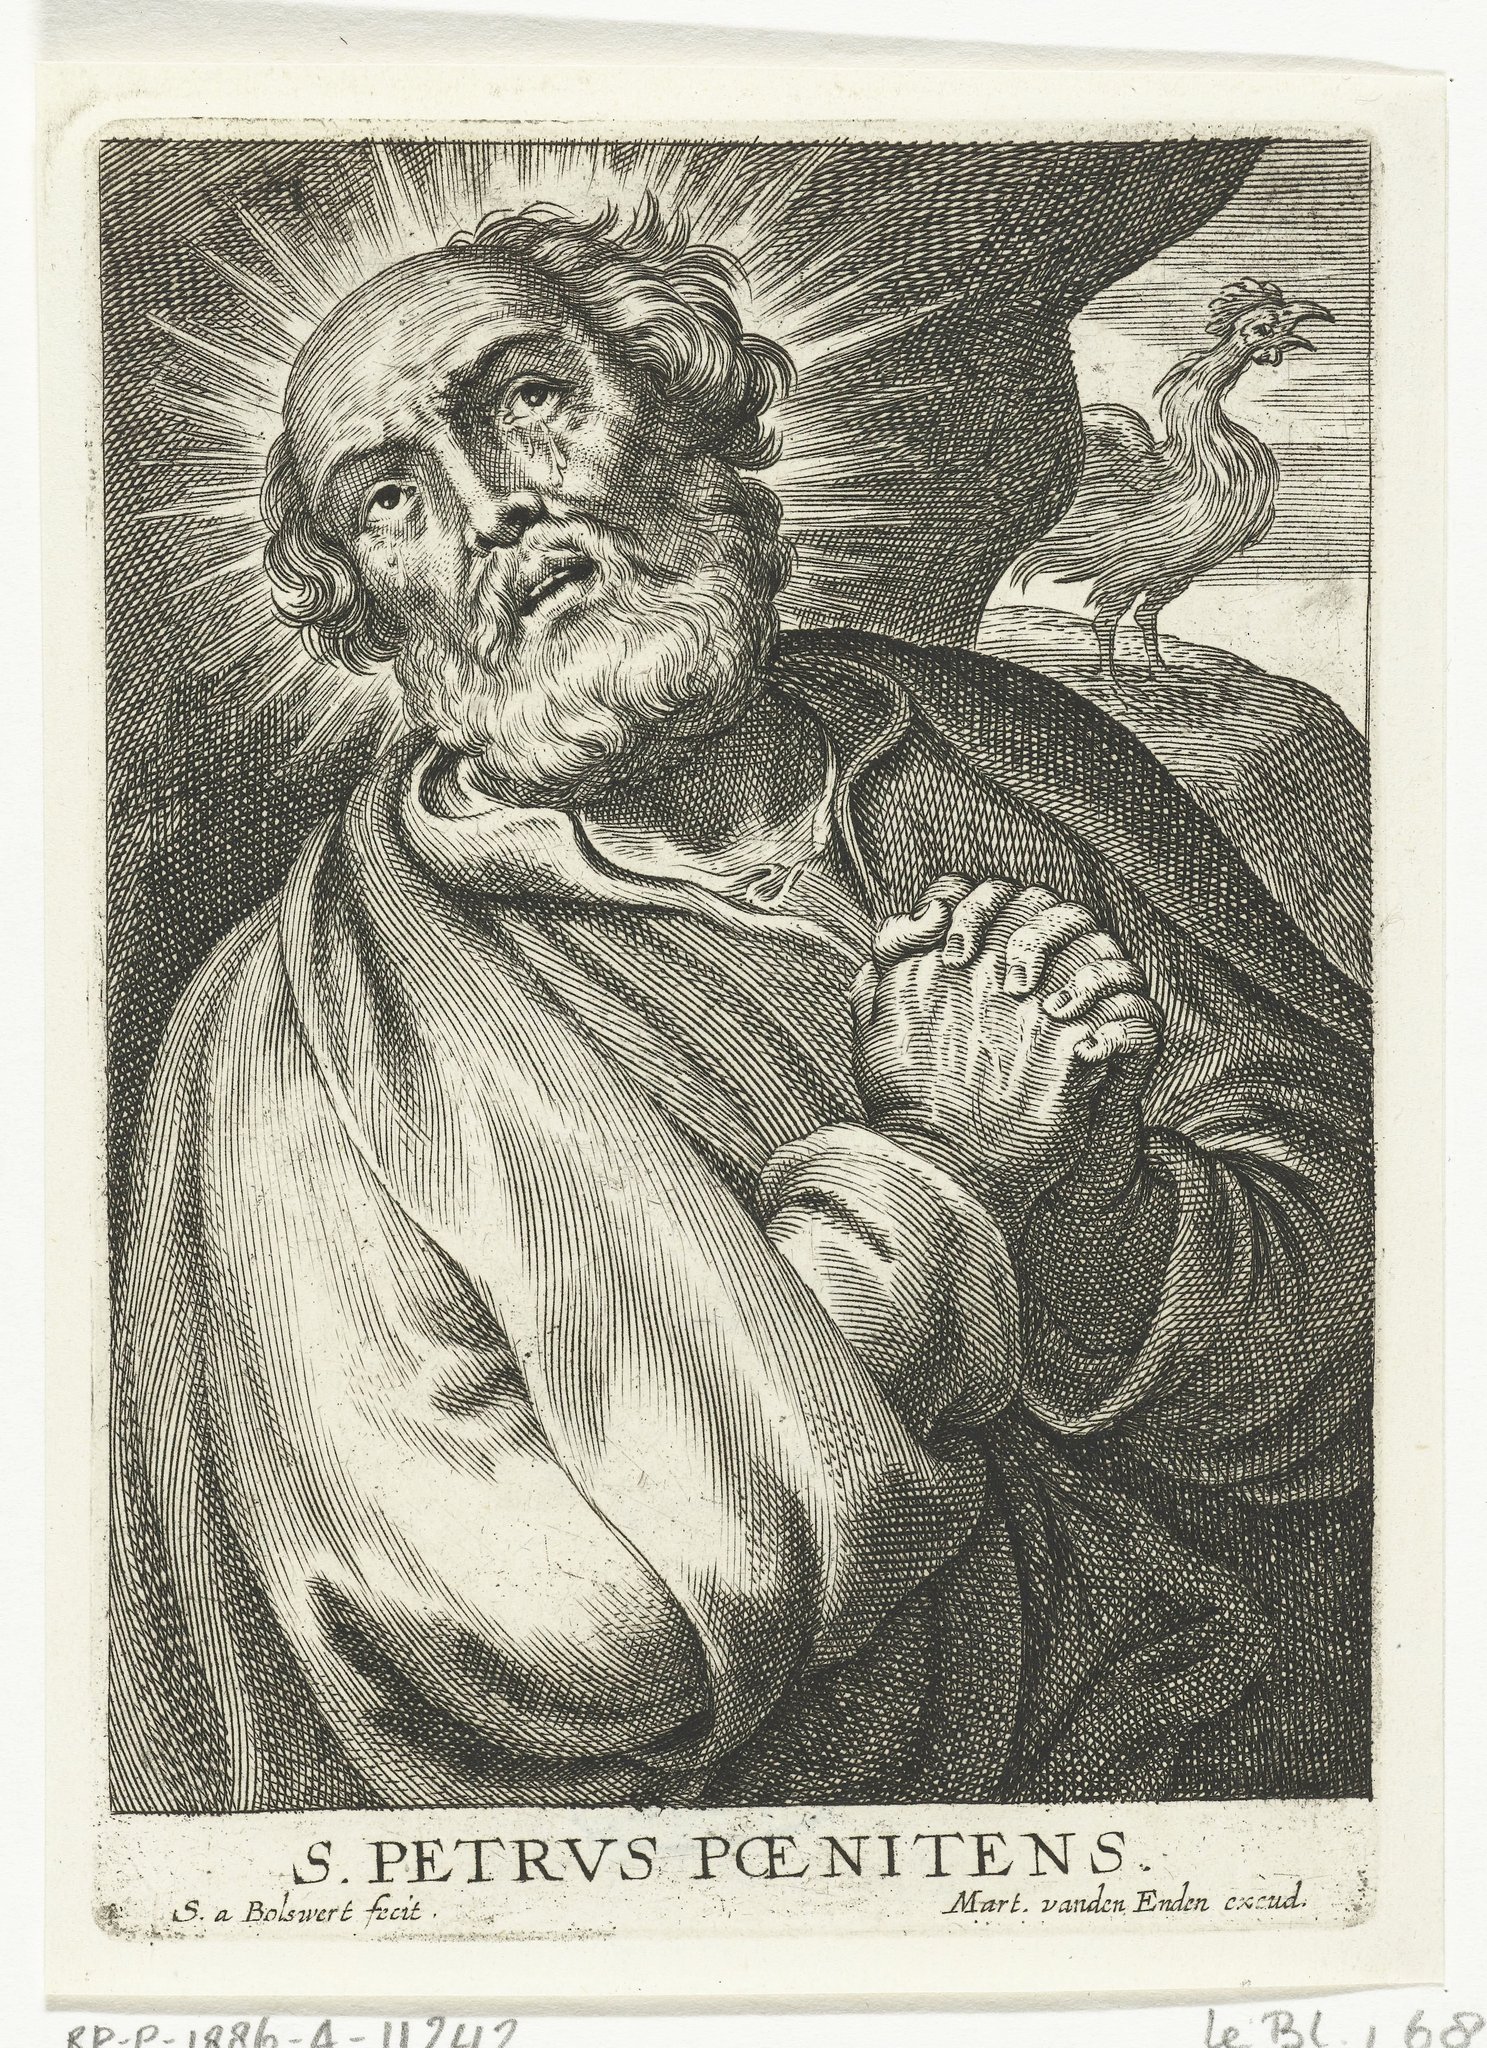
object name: print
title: Heilige Petrus doet boete voor verraad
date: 1596-1659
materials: paper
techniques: engraving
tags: the apostle peter, first bishop of rome; possible attributes: book, cock, (upturned) cross, (triple) crozier, fish, key, scroll, ship, tiara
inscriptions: collector's mark: Lugt 2228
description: Prent uit serie Vélins met negentig prenten naar ontwerp van Peter Paul Rubens. In de bronnen vinden we uiteenlopende gegevens over aantal en samenstelling van de serie. Hollstein hanteert het aantal van negentig prenten. De reeks Vélins in de collectie van het RMA bevat verschillende staten afkomstig uit meerdere uitgaven welke moeilijk te duiden zijn. Sommige dragen het originele adres van Schelte Adamsz. Bolswert als graveur en uitgever, op andere exemplaren is deze naam verwijderd (duidelijk zichtbaar!) en vervangen door de naam Cornelis Galle (II). De prenten met de naam van uitgever Galle zijn vaak opgewerkt. We treffen nog een andere naam van een uitgever bij enkele prent aan: Martien van den Enden. Herkomst uit meerdere uitgaven spreekt ook uit afwijkende opschriften in Nederlands en Latijn en variaties op dezelfde thema's welke misschien nooit langs elkaar in dezelfde serie gebruikt werden.